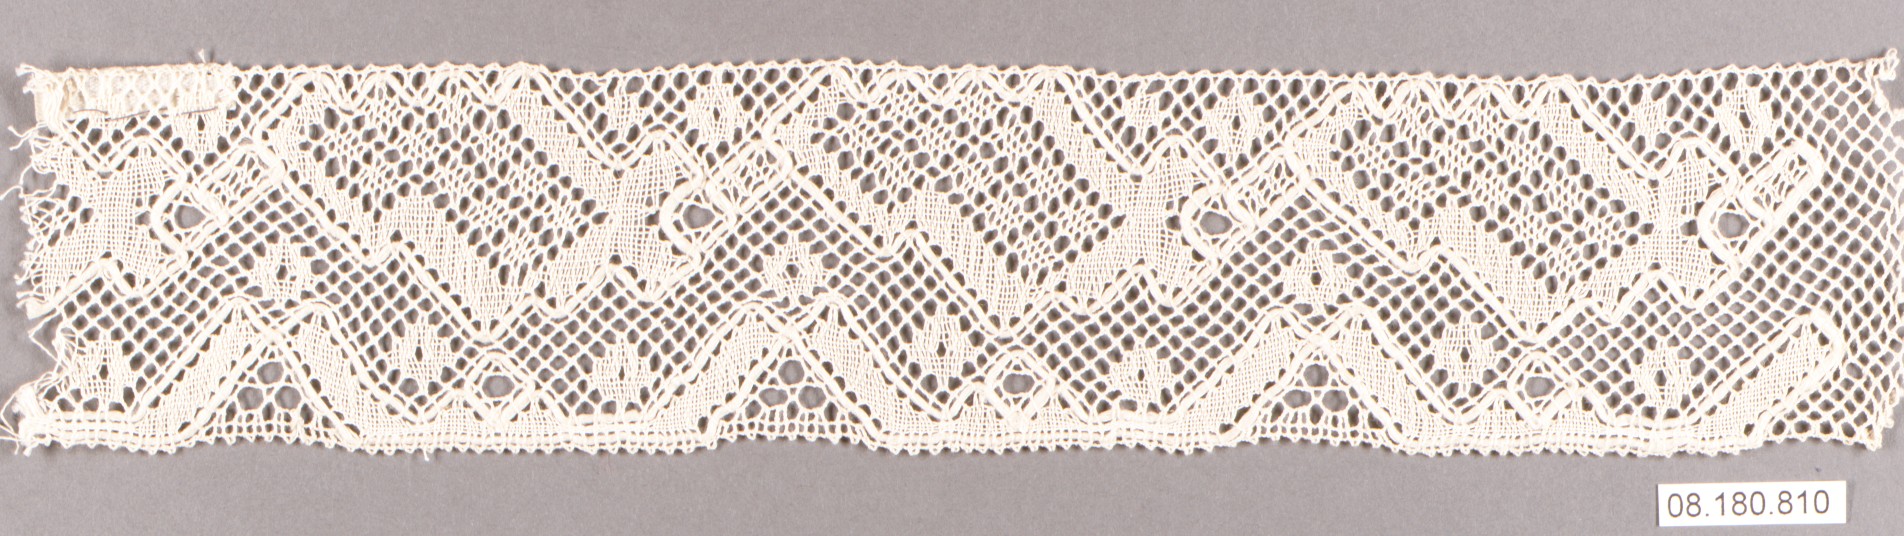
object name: fragment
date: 1801-1900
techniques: lace